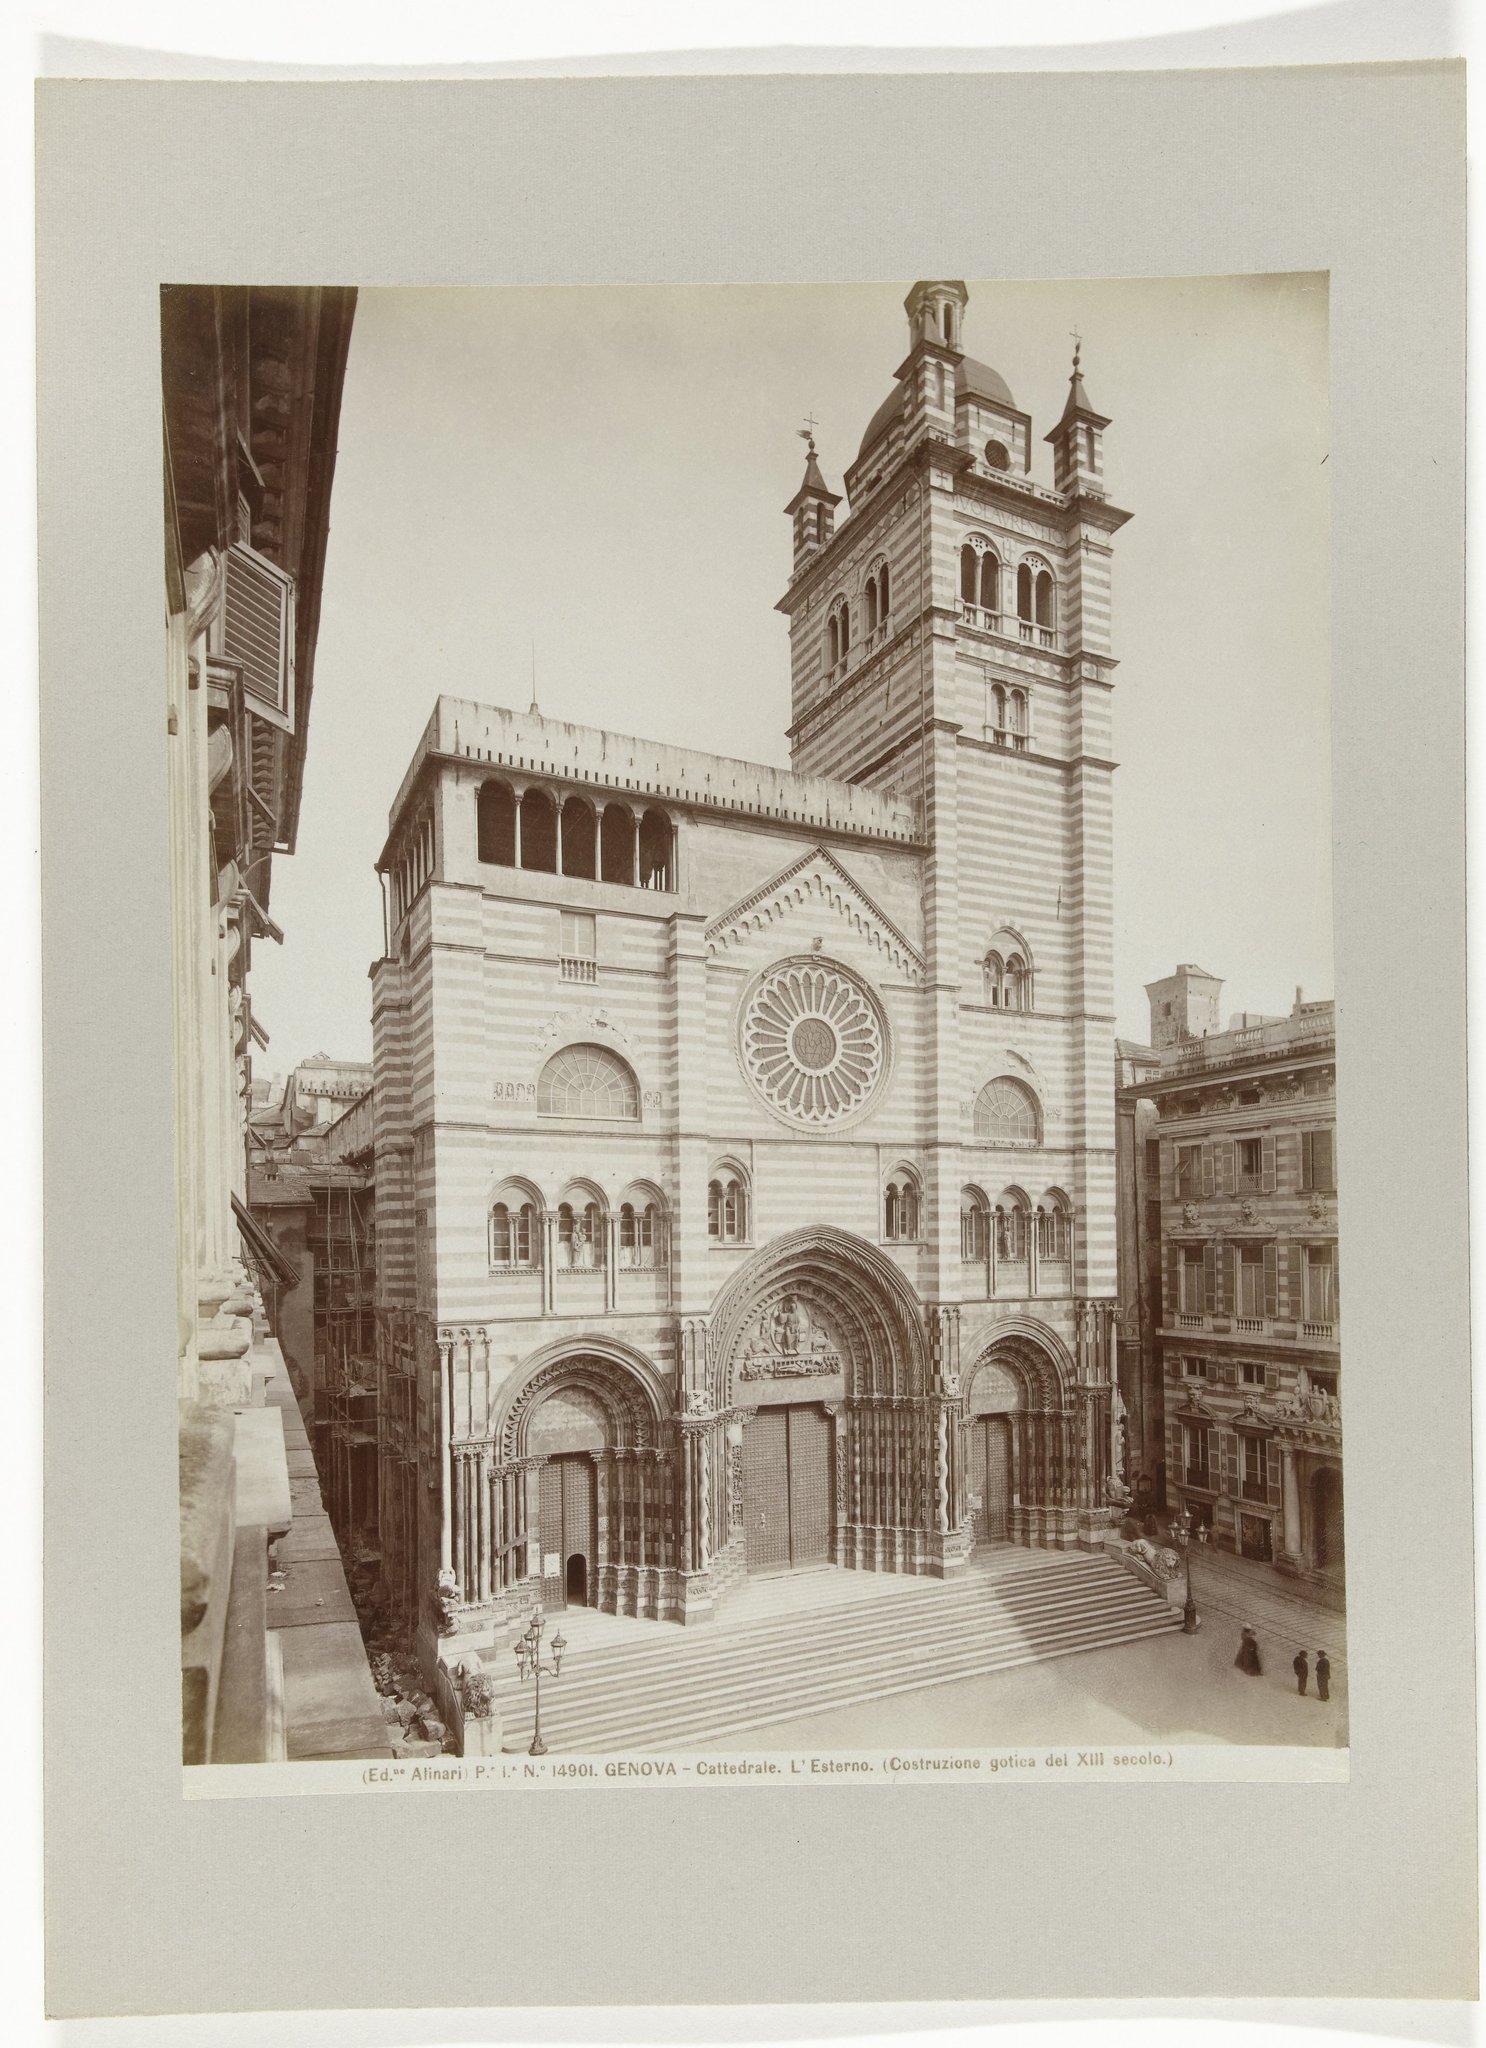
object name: photograph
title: P.e 1.a N.o 14901. GENOVA - Cattedrale. L'Esterno. (Costruzione gotica del XIII secolo.)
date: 1898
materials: cardboard, paper, photographic support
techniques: albumen print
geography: florence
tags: church (exterior)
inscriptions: number: ‘98.’